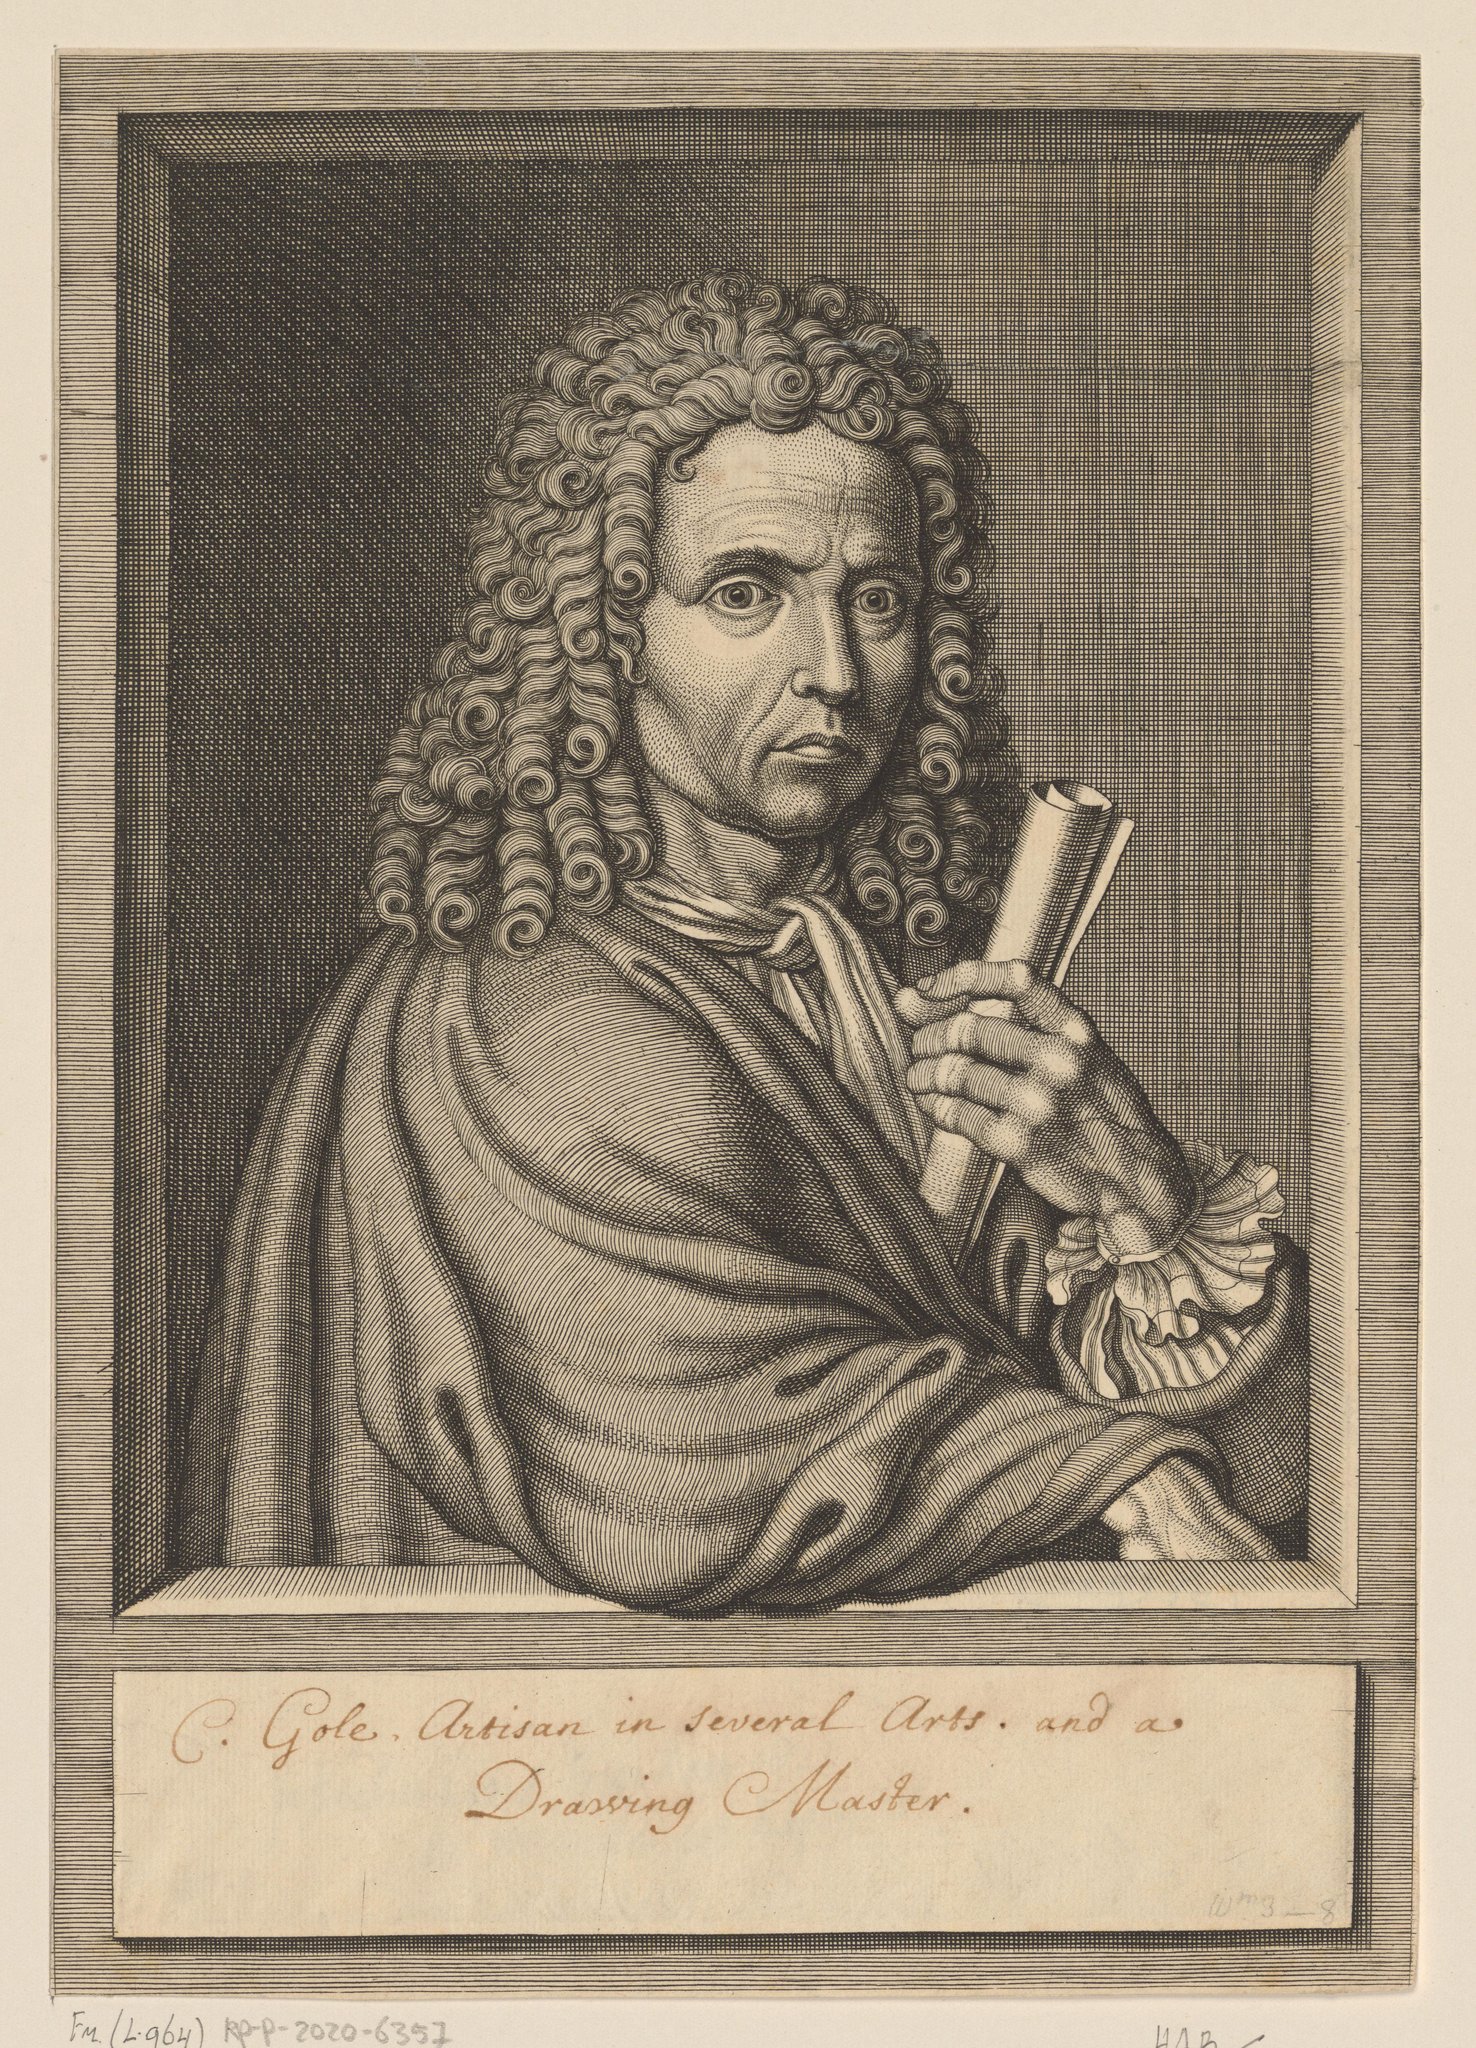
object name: print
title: Portret van Corneille Gole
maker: Anonymous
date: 1667-1732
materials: paper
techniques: engraving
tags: furniture worker, corneille gole, historical persons, writer, poet, author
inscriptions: collector's mark: Lugt 964